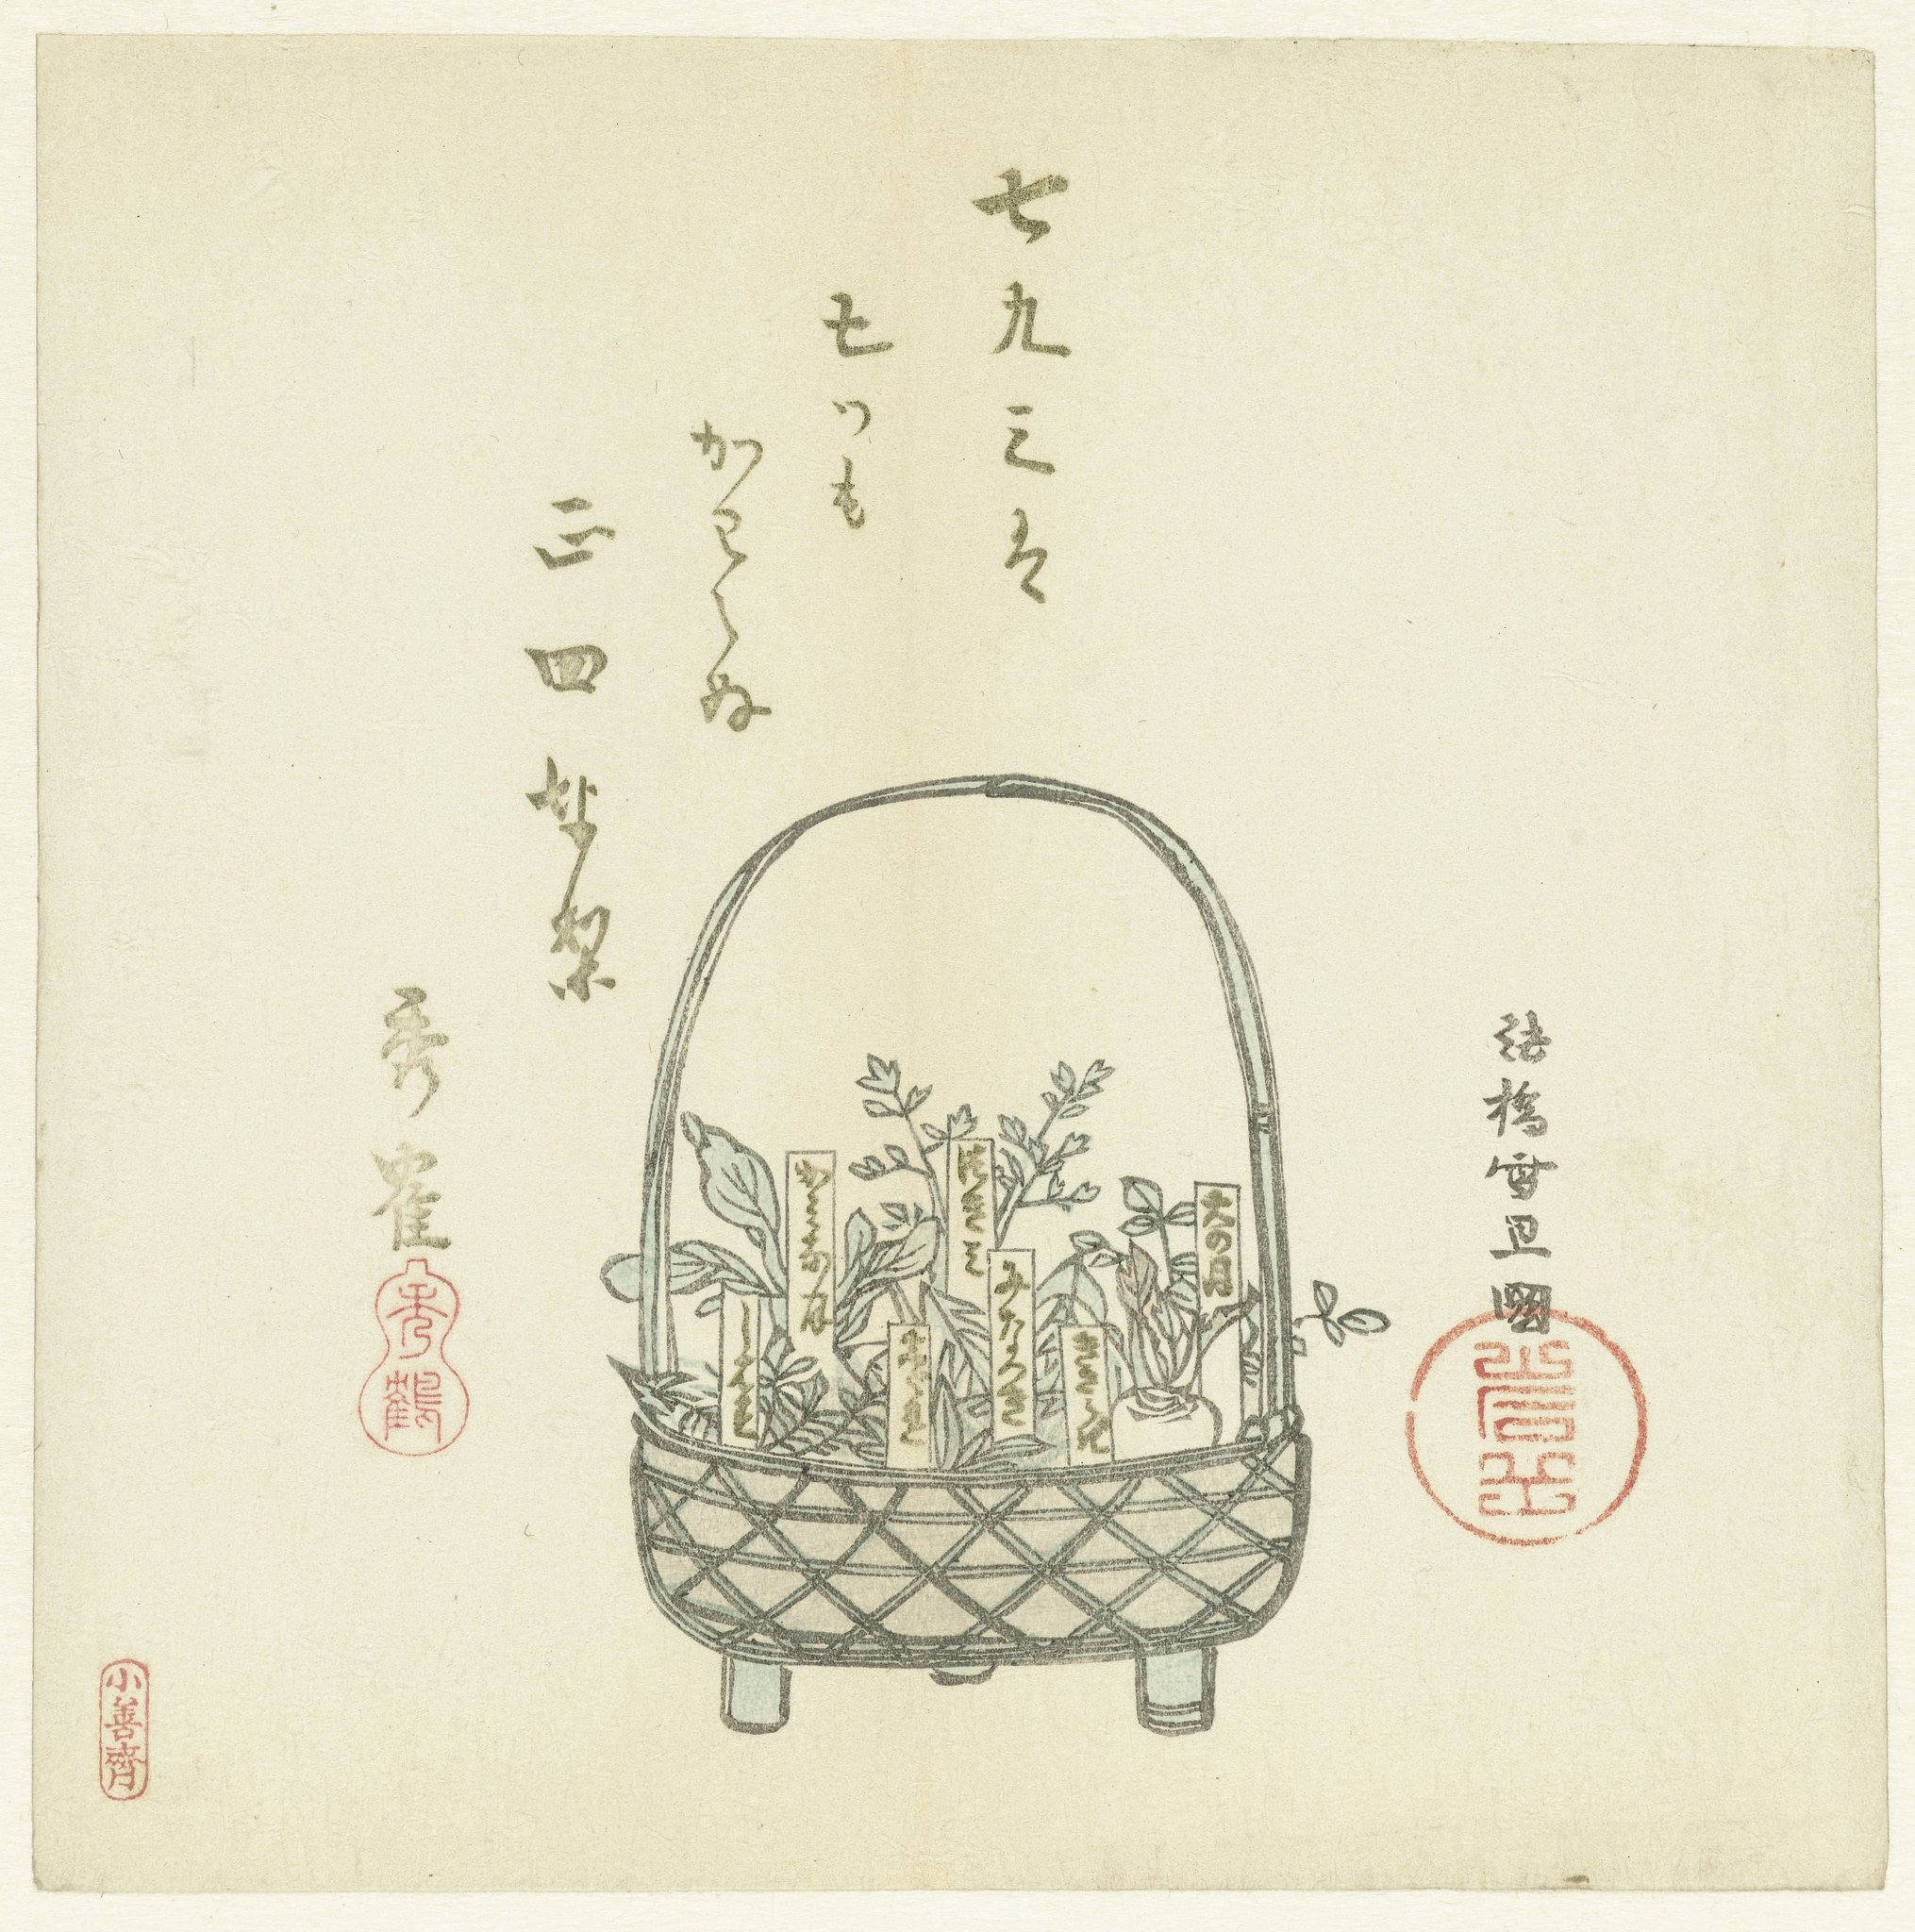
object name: egoyomi kalenderblad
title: A Basket of Young Shoots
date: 1831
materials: paper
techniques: woodcut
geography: japan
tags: container made of plant material other than wood: basket, plants and herbs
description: Een surimono is een luxe uitgevoerde prent waarop beeld met één of meerdere gedichten gecombineerd is. Bij het drukken van een surimono werd vaak gebruik gemaakt van dikker papier, blinddruk en metaal pigmenten, zoals koper- en zilverpoeder. De prenten werden vaak in opdracht van dichters gemaakt en als exclusief geschenk aan vrienden en relaties gegeven. Een egoyomi is een kalender prent, waarop de aanduiding voor de maanden verstopt zit in het ontwerp. Vaak werden egoyomi net als surimono in eigen beheer uitgegeven en aan vrienden kado gedaan. In Japan gebruikte men tot 1873 een maankalender, waarbij de volgorde van de lange en de korte maanden jaarlijks varieerde. Omdat er maar een klein aantal uitgevers kalenders mocht maken, waren particulier uitgeven kalender prenten tegen de regels van de overheid. Om deze regels te omzeilen werden de kalendergegevens verstopt in het prentontwerp.